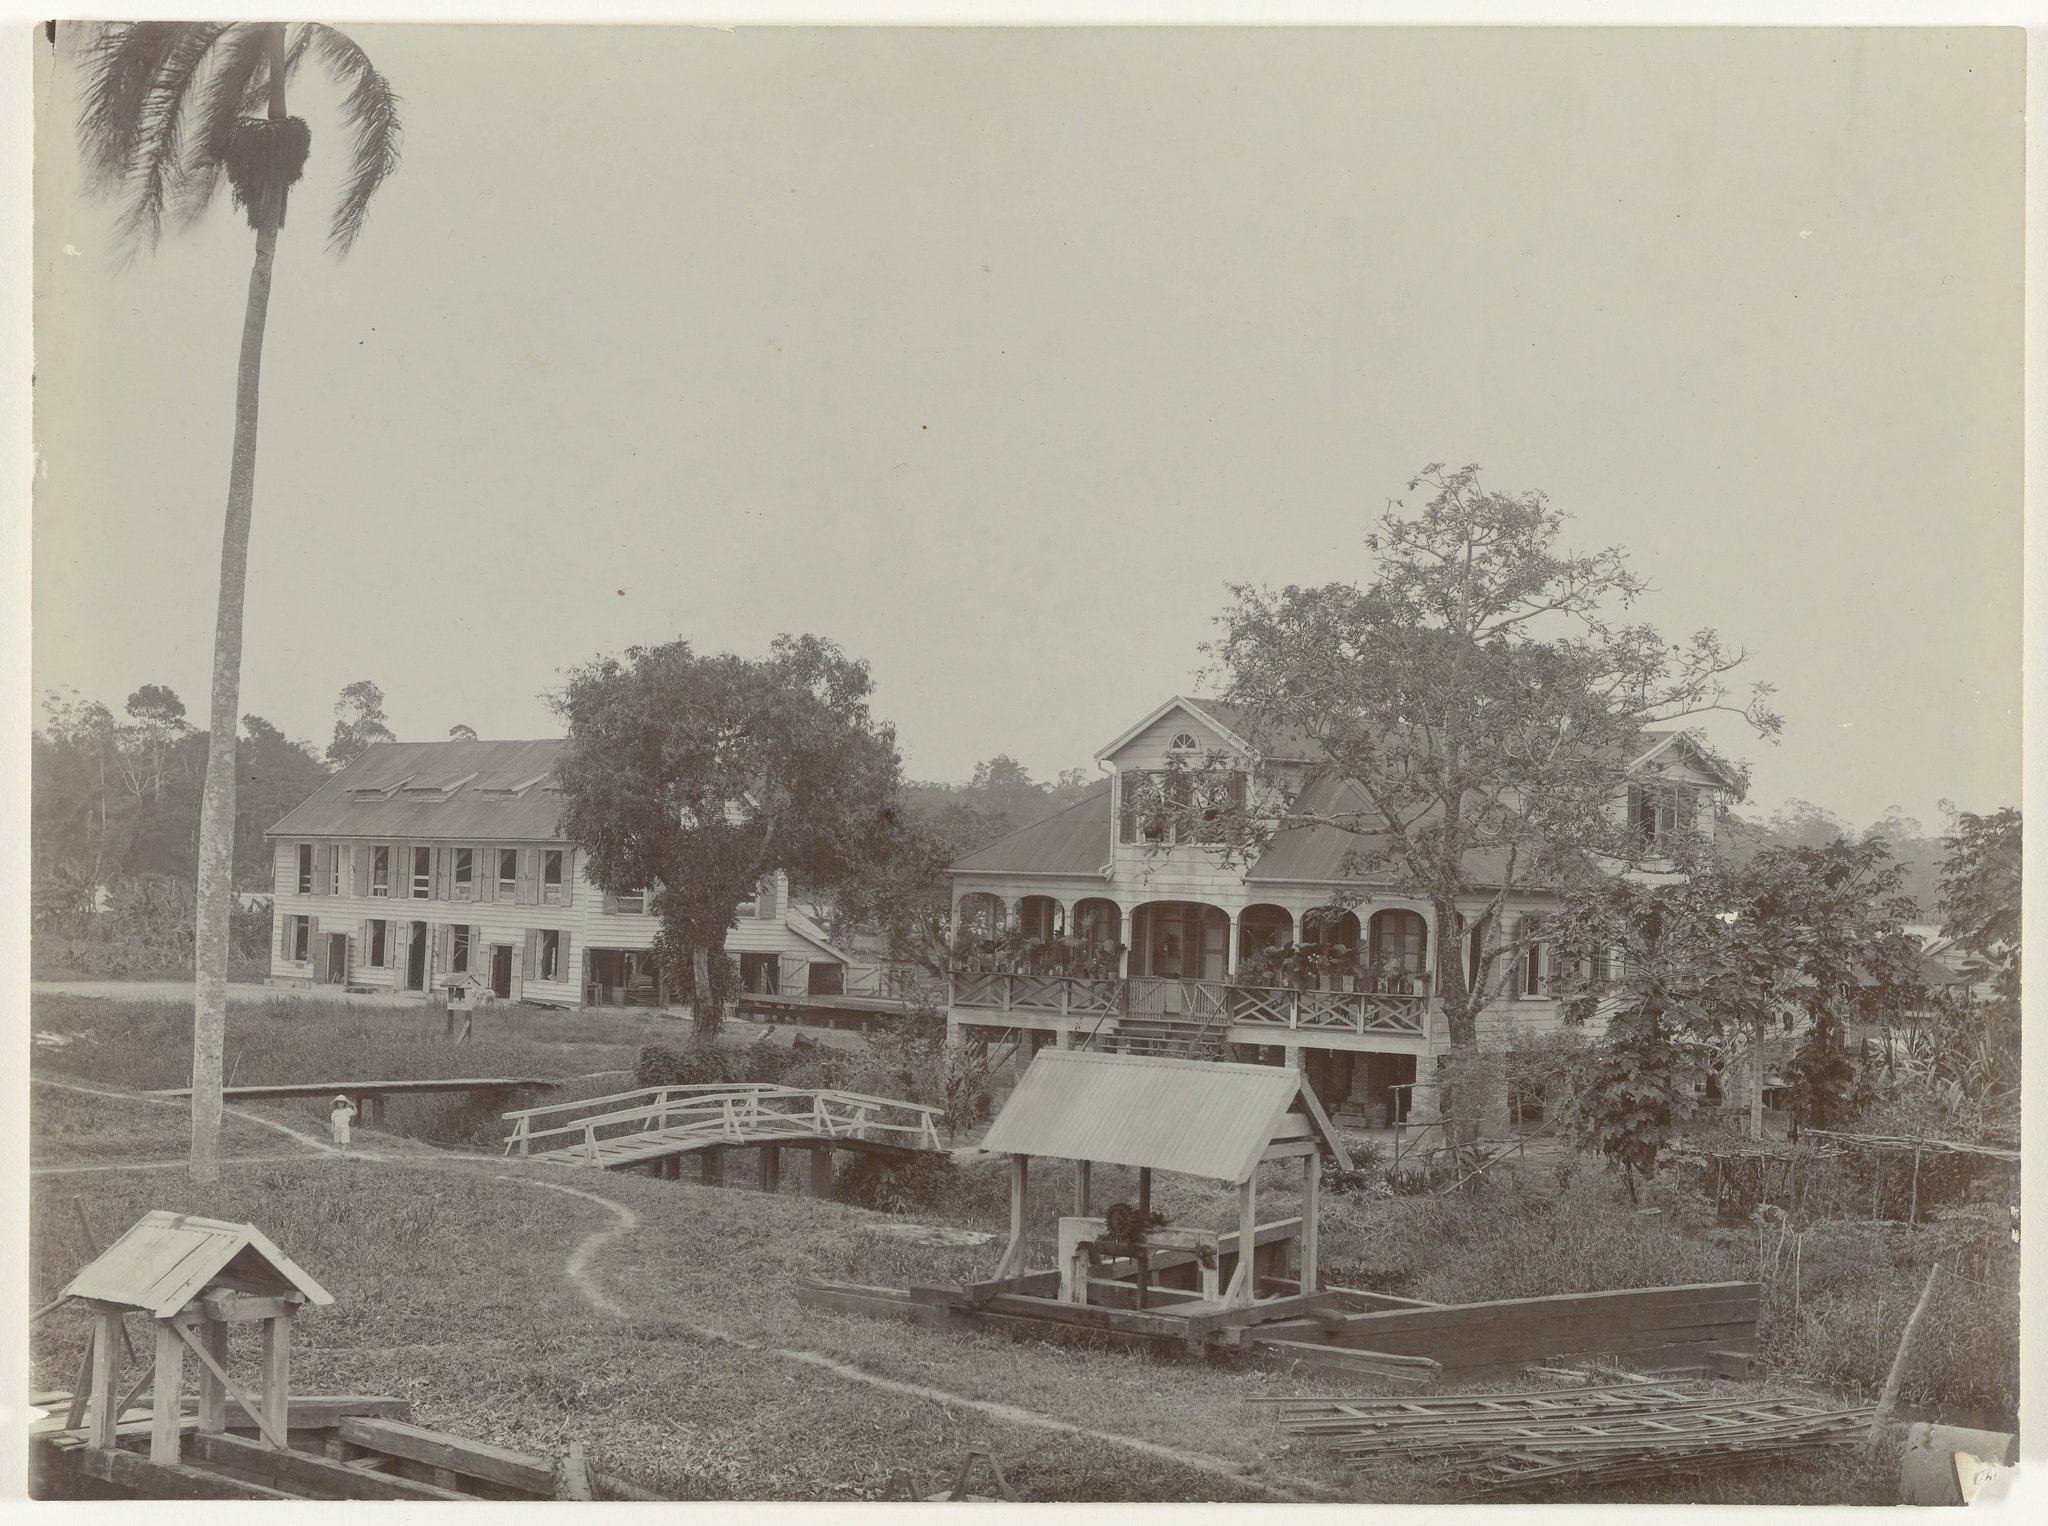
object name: photograph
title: Huis op plantage Johanna Catharina te Suriname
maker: theodoor brouwers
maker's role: amateurfotograaf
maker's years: 1874-1932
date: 1918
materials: photographic support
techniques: gelatin silver print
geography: suriname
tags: amsterdam, theodoor brouwers, plantation, suriname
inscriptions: inscription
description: Gezicht op houten gebouwen van plantage Johanna-Catharina aan de overzijde van een vaart. Het meisje links op de foto is Doortje Brouwers, de dochter van planter Theodoor Brouwers.